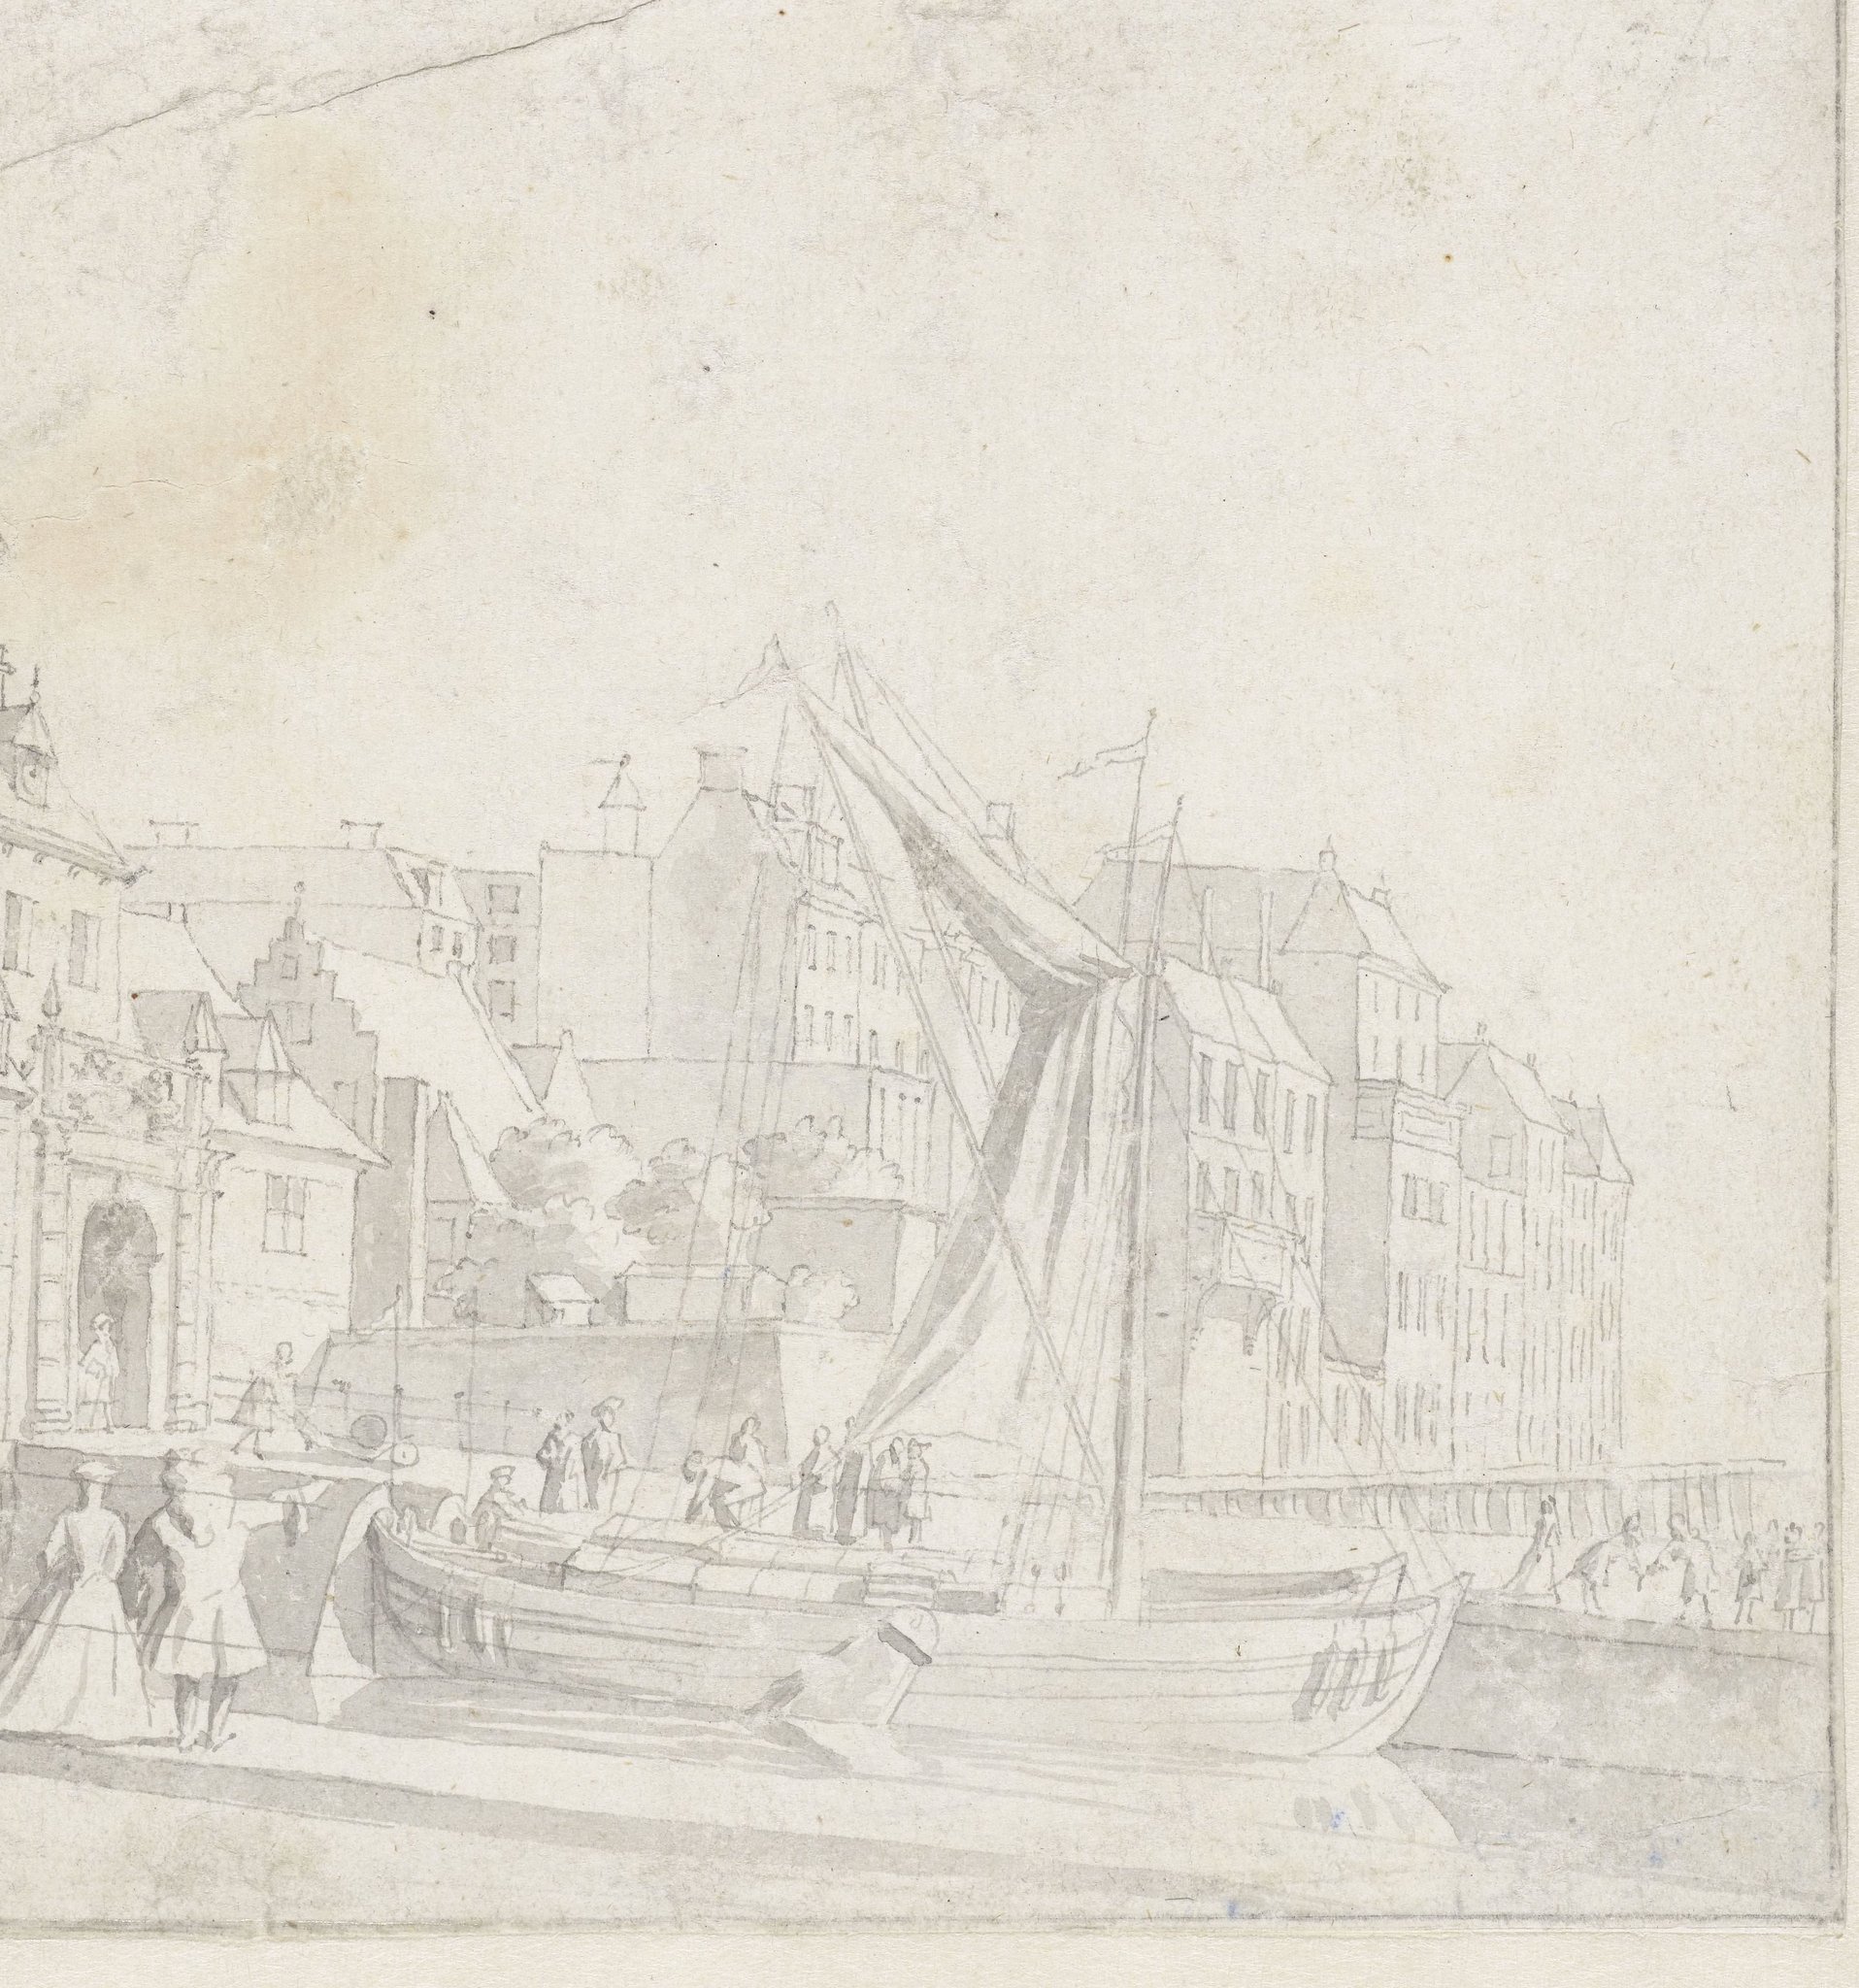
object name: drawing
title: De Hoofdpoort op het Oude Hoofd te Rotterdam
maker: cornelis pronk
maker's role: draughtsman, painter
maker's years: 1691-1759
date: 1701-1759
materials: ink, paper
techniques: brush, pen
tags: harbour, canals, waters (in city)